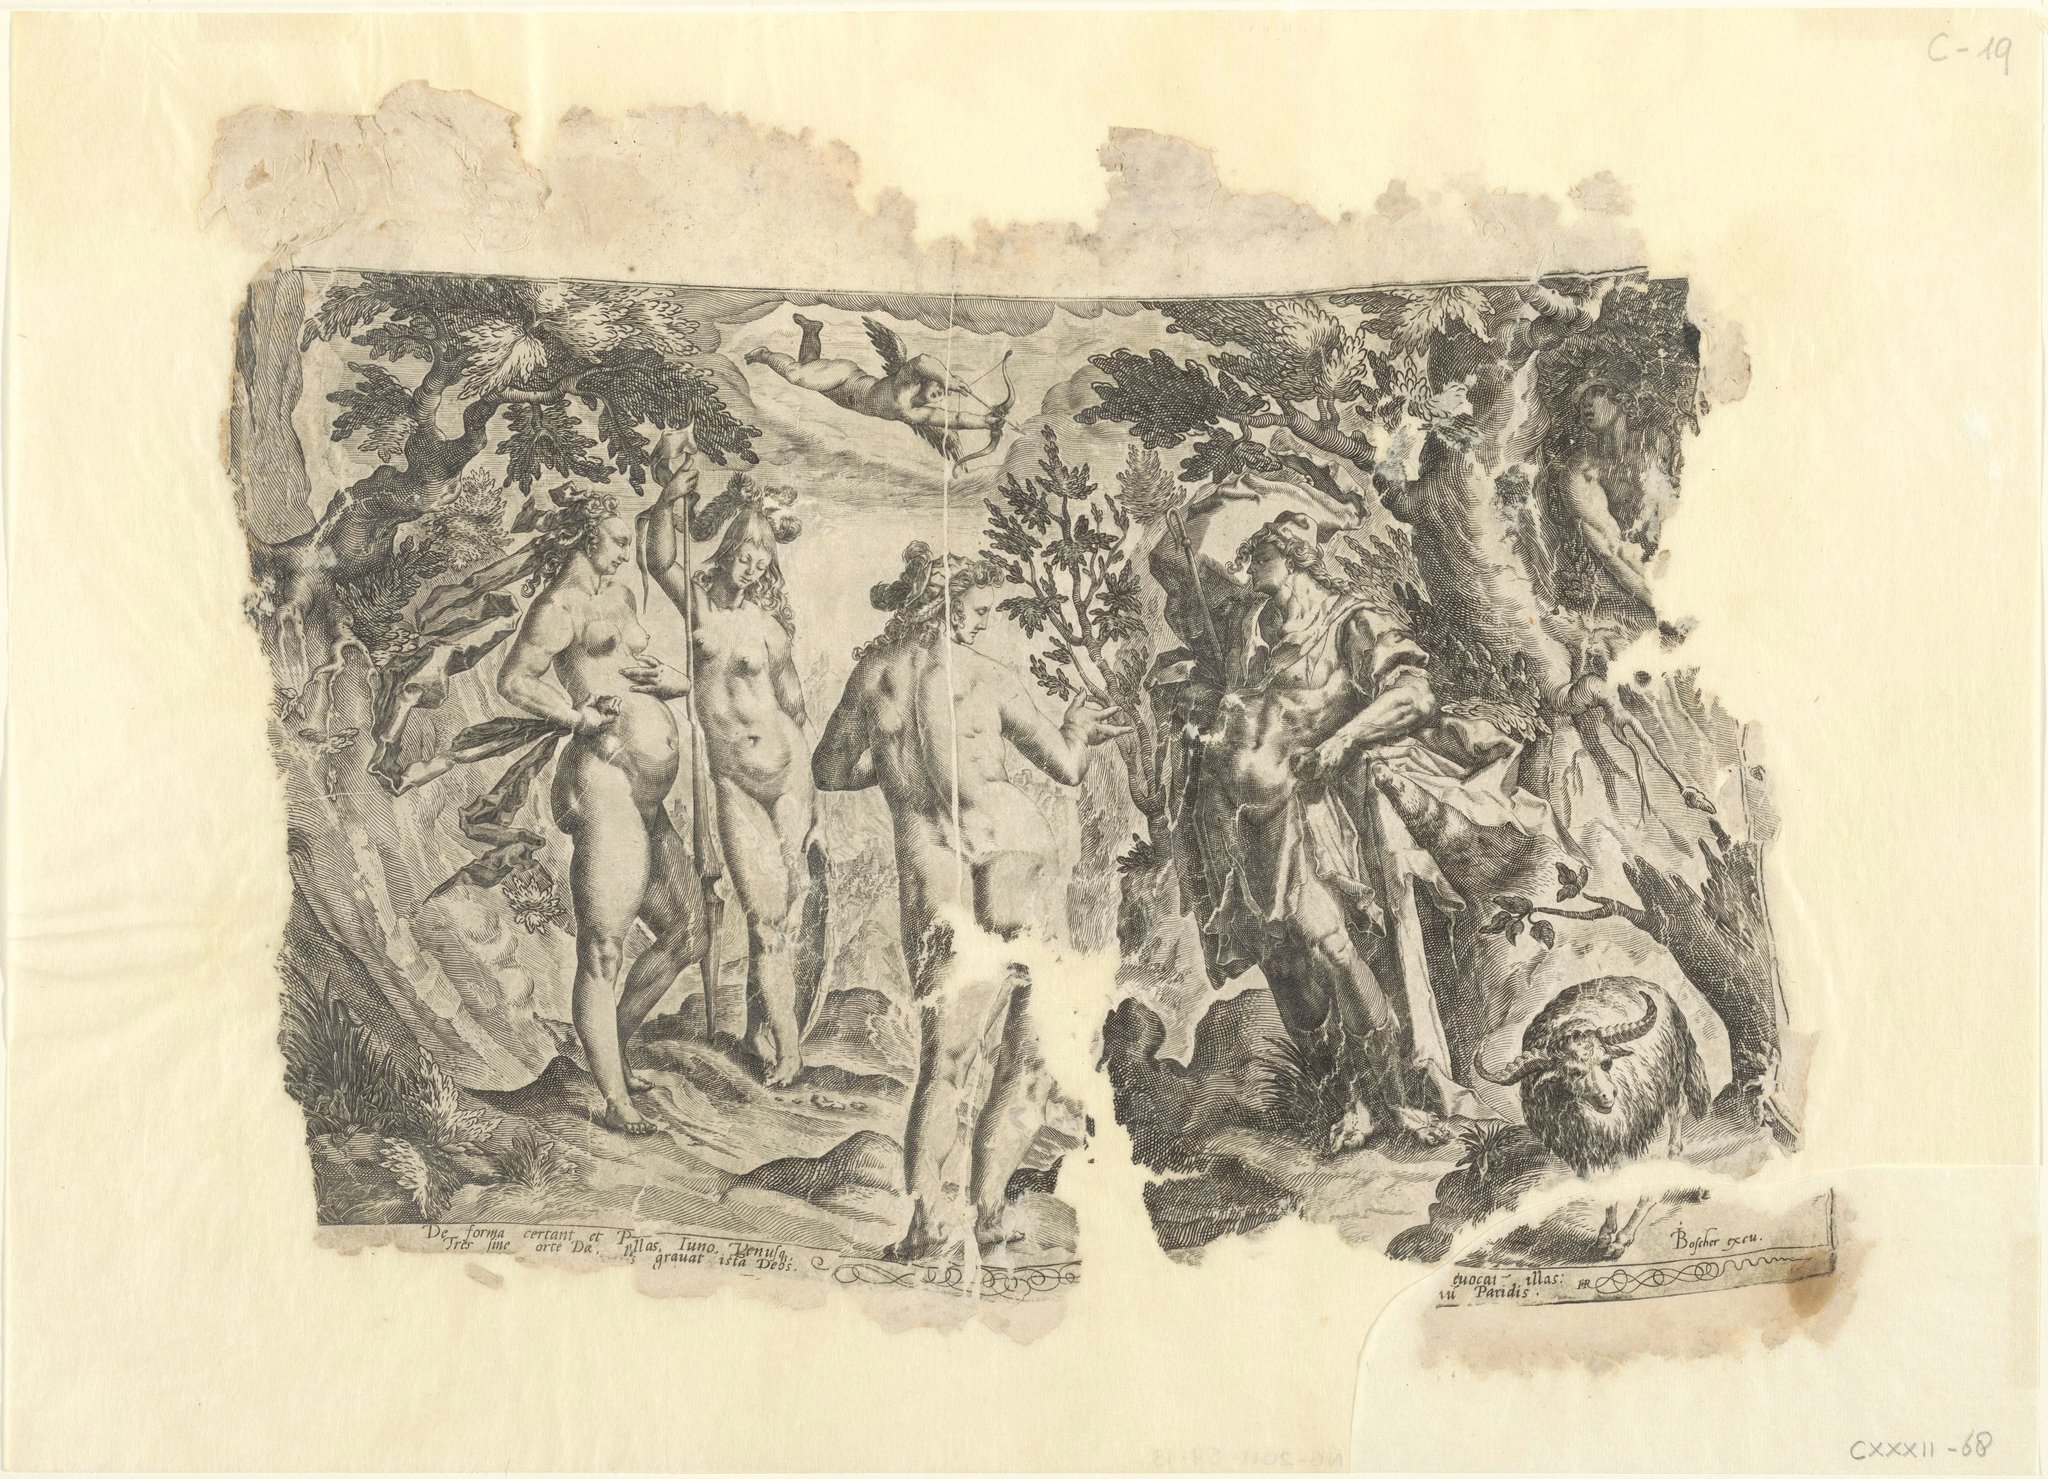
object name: print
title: Oordeel van Paris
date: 1580-1596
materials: paper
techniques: engraving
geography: amsterdam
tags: the judgement of paris (mercury present)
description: De prenten in de Nova Zembla collectie zijn tijdens een expeditie van Willem Barendsz en Jacob van Heemskerk in 1596-1597 noodgedwongen in het winterkamp, het ‘Behouden Huis’, op het eiland achtergelaten. De prenten waren in één of meerdere stapels als handelswaar meegenomen vanuit Amsterdam. Bijna drie eeuwen later, in 1871, keerde de Noor Elling Carlsen terug naar Nova Zembla en vond daar de restanten van het ‘Behouden Huis, inclusief een groot deel van de inventaris. Een deel van de prenten, in de vorm van aaneengekoekte kluiten, werd toen ook teruggevonden. De papierkluiten waren soms op meerdere plekken gebroken. Tussen 1975-1979 zijn de prenten van elkaar gescheiden. Dit leverde in totaal ca. 1000 fragmenten van ca. 400 afdrukken van ca. 150 verschillende prenten op. Voor zover mogelijk zijn de fragmenten samengevoegd en zijn de prenten gereconstrueerd.